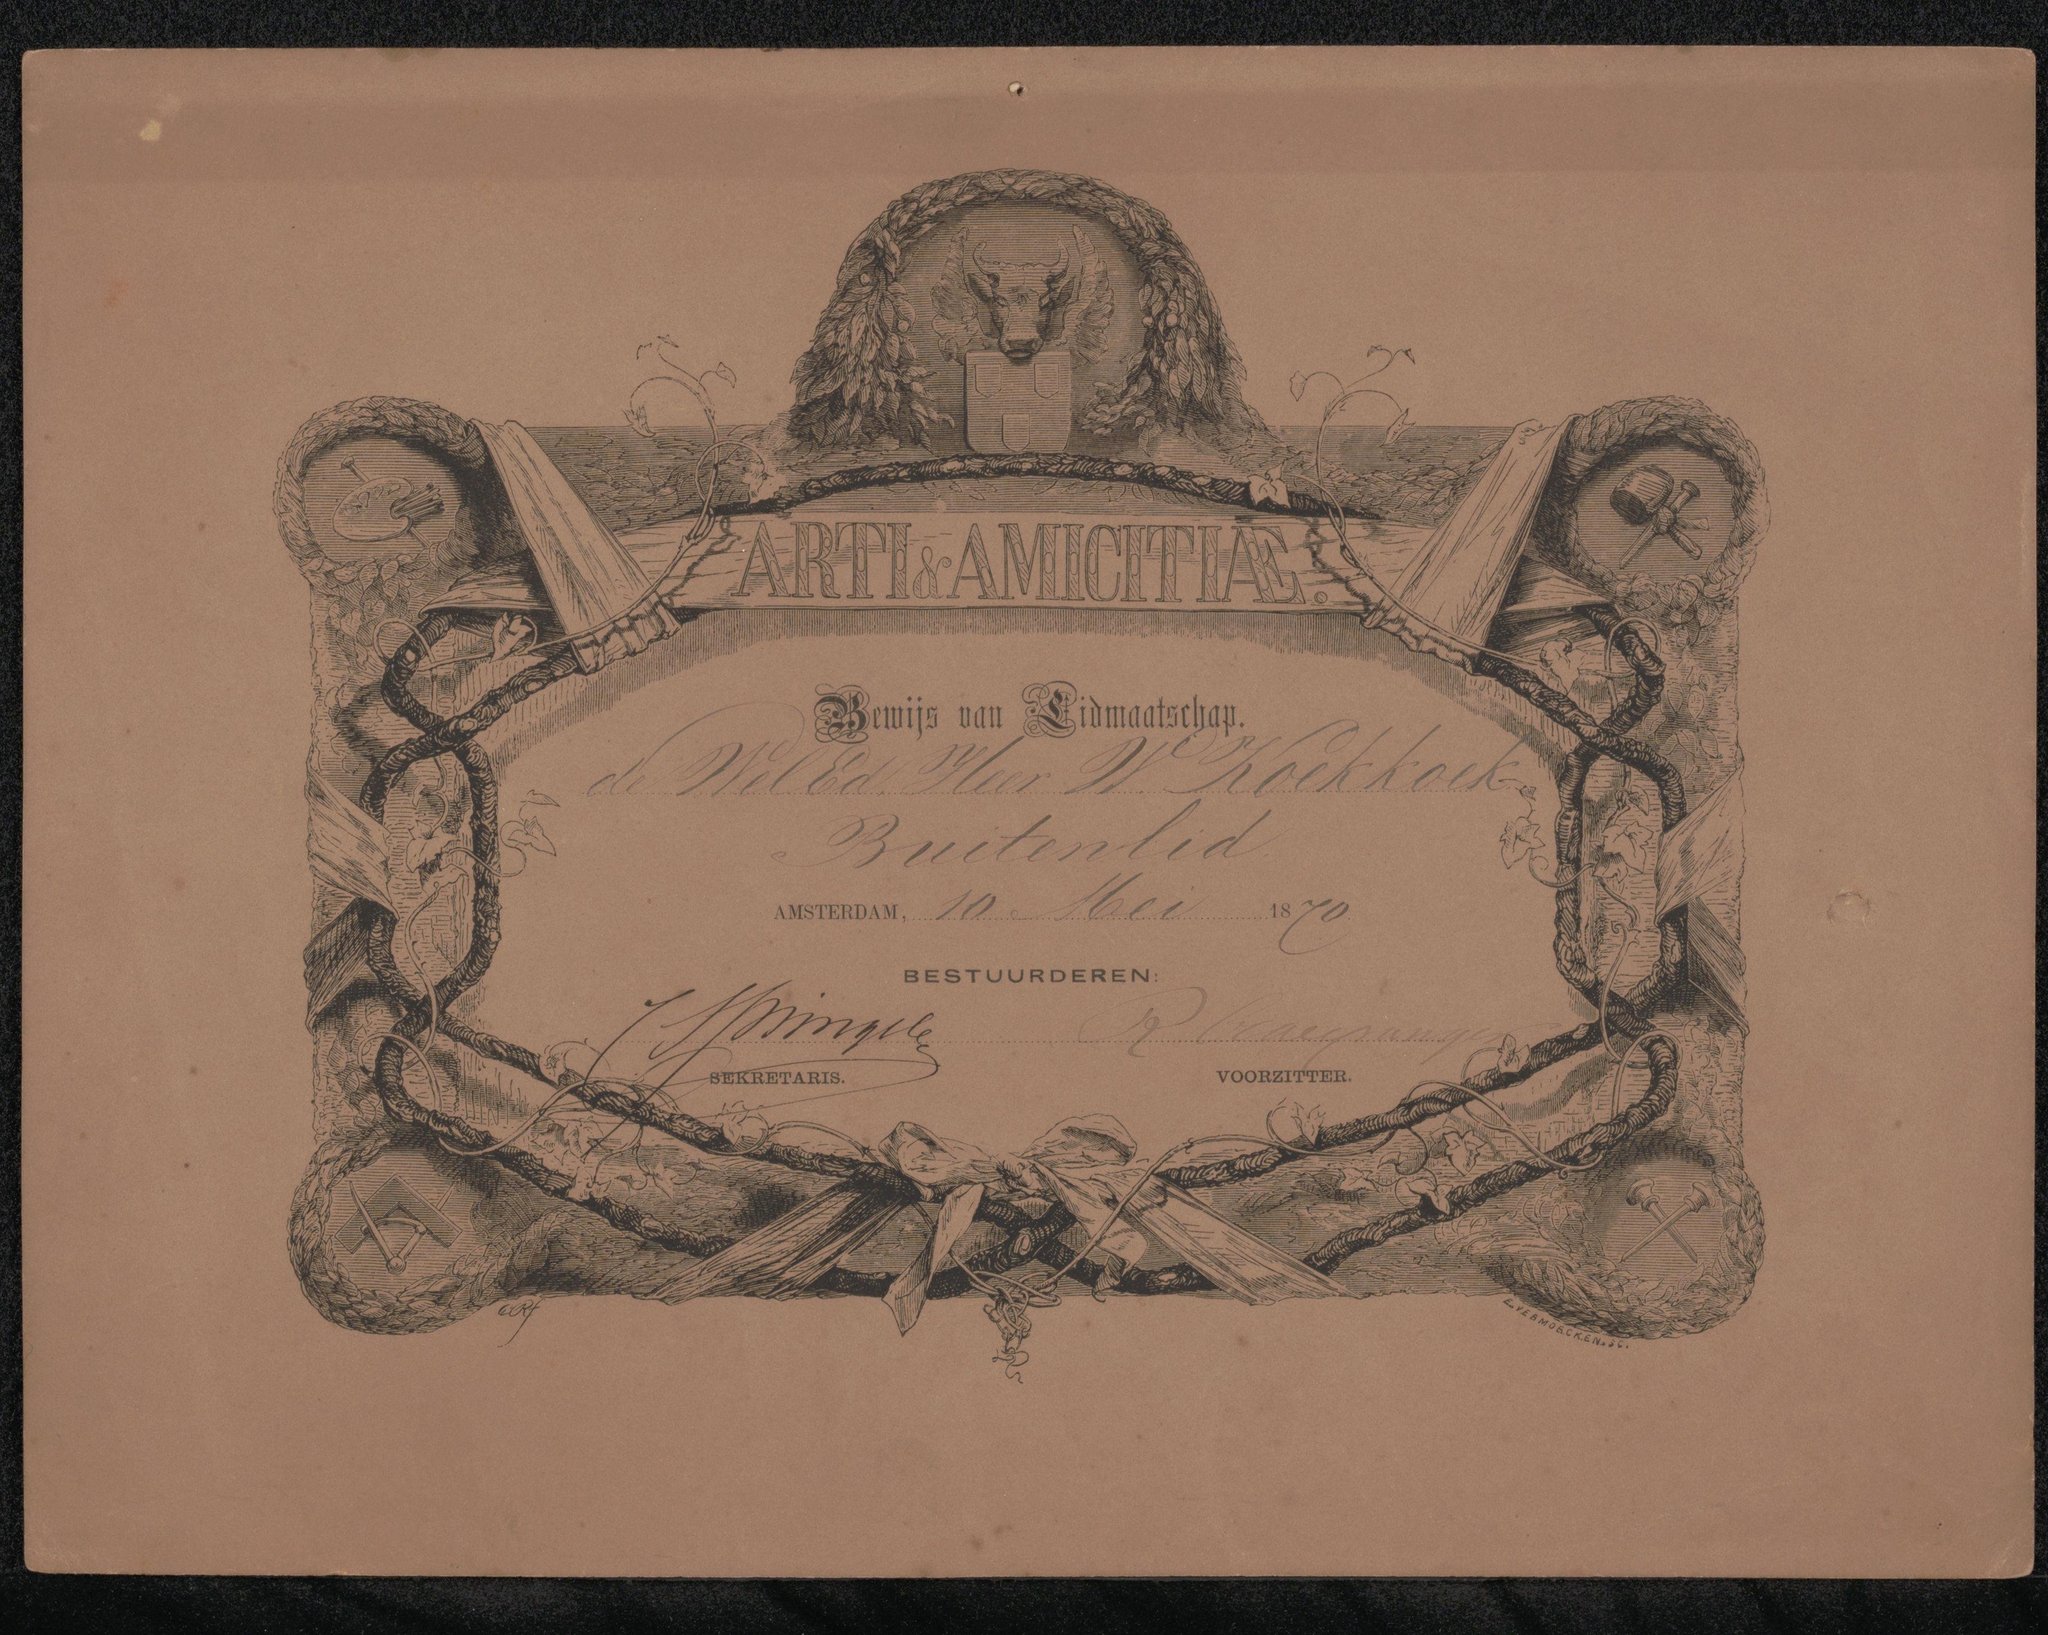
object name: membership certificate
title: Lidmaatschapsbewijs van Willem Koekkoek van Arti et Amicitiae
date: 1870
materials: ink, paper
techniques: lithograph, pen, writing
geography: amsterdam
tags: willem koekkoek